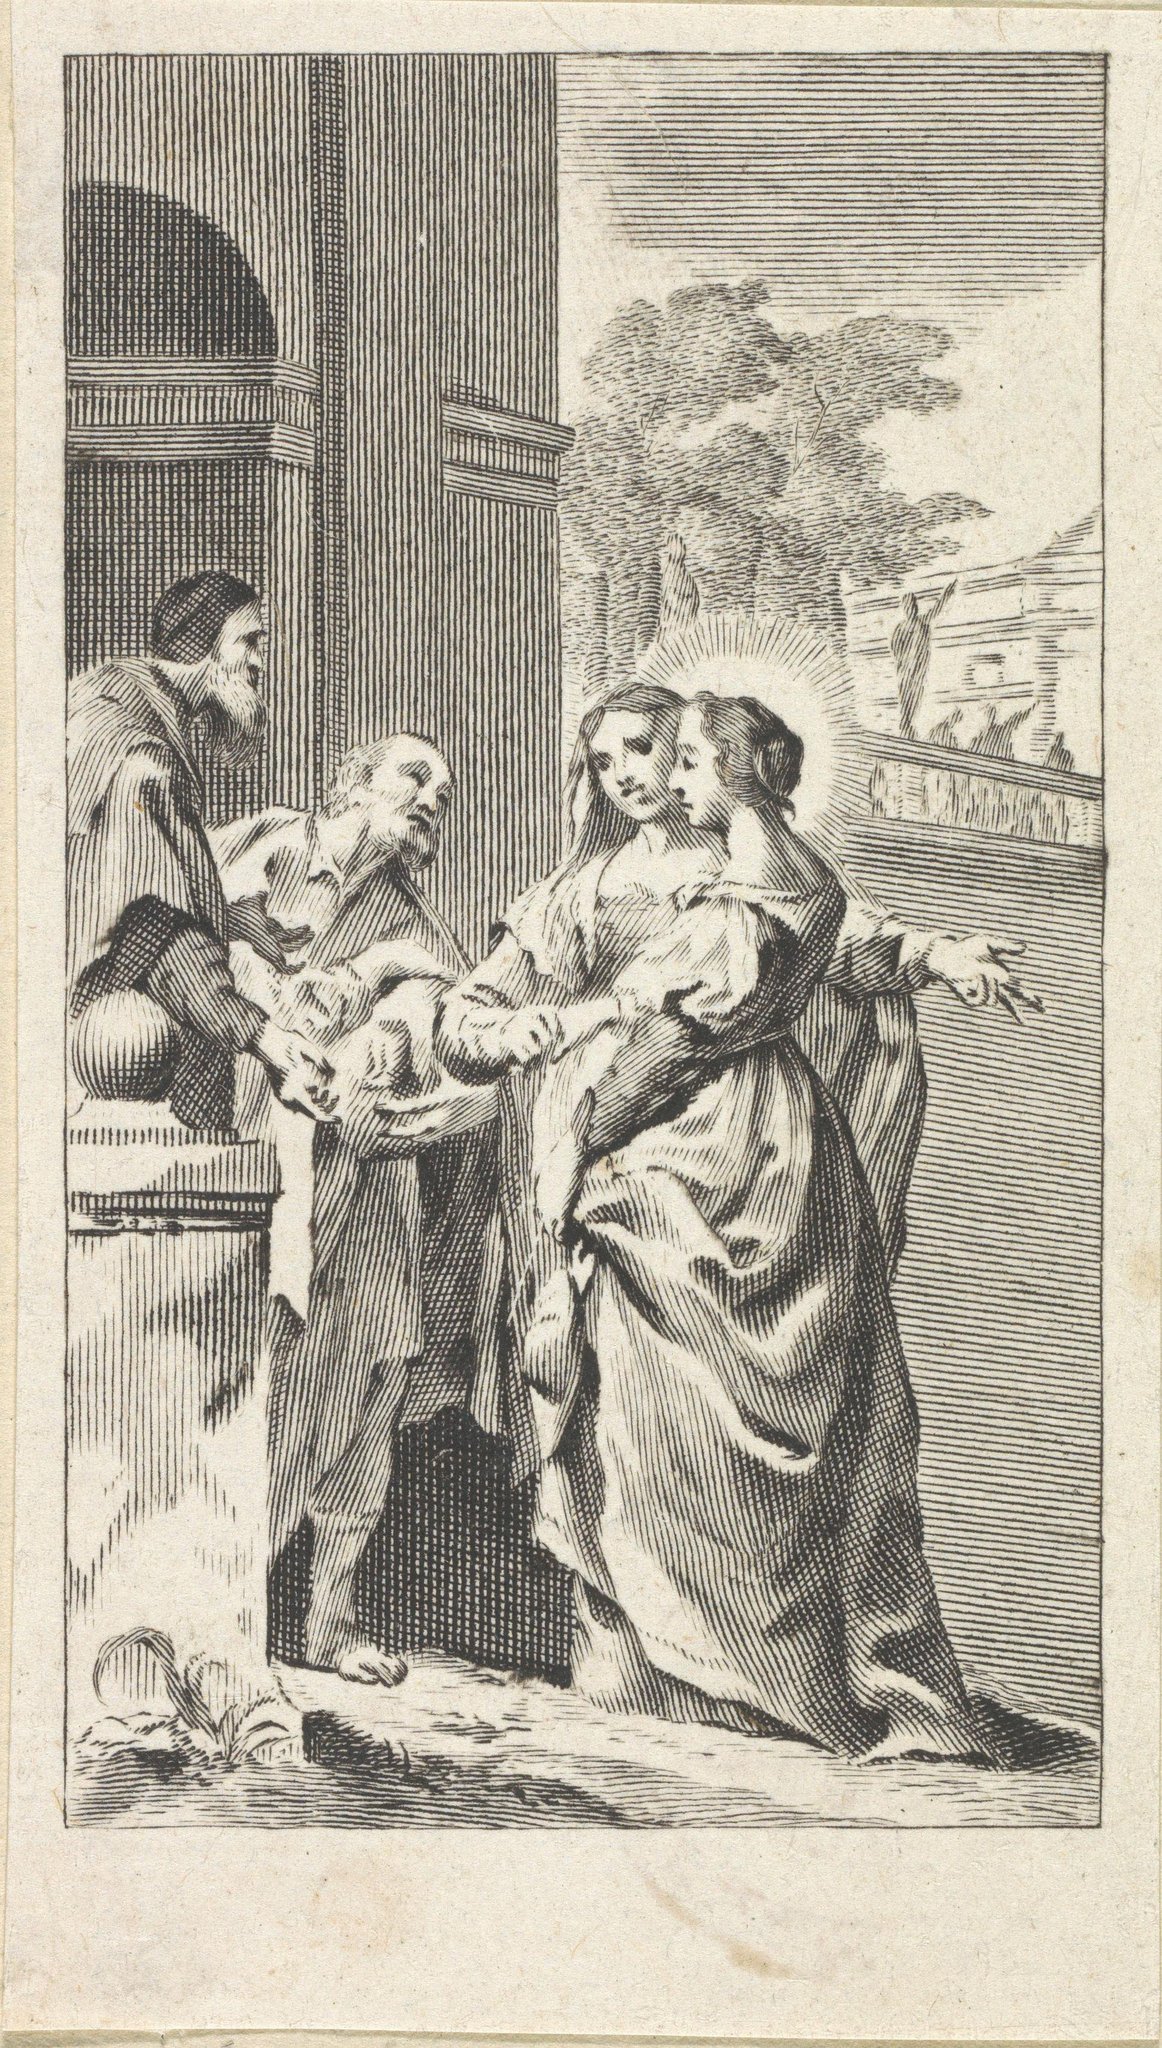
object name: print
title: Visitatie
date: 1740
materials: paper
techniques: engraving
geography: venice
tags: visitation (possibly joseph and/or zacharias present) (luke 1:39-56), meeting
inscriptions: collector's mark: Lugt 240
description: Het bezoek van Maria aan haar nicht Elisabet. Jozef en Zacharias zijn ook aanwezig.